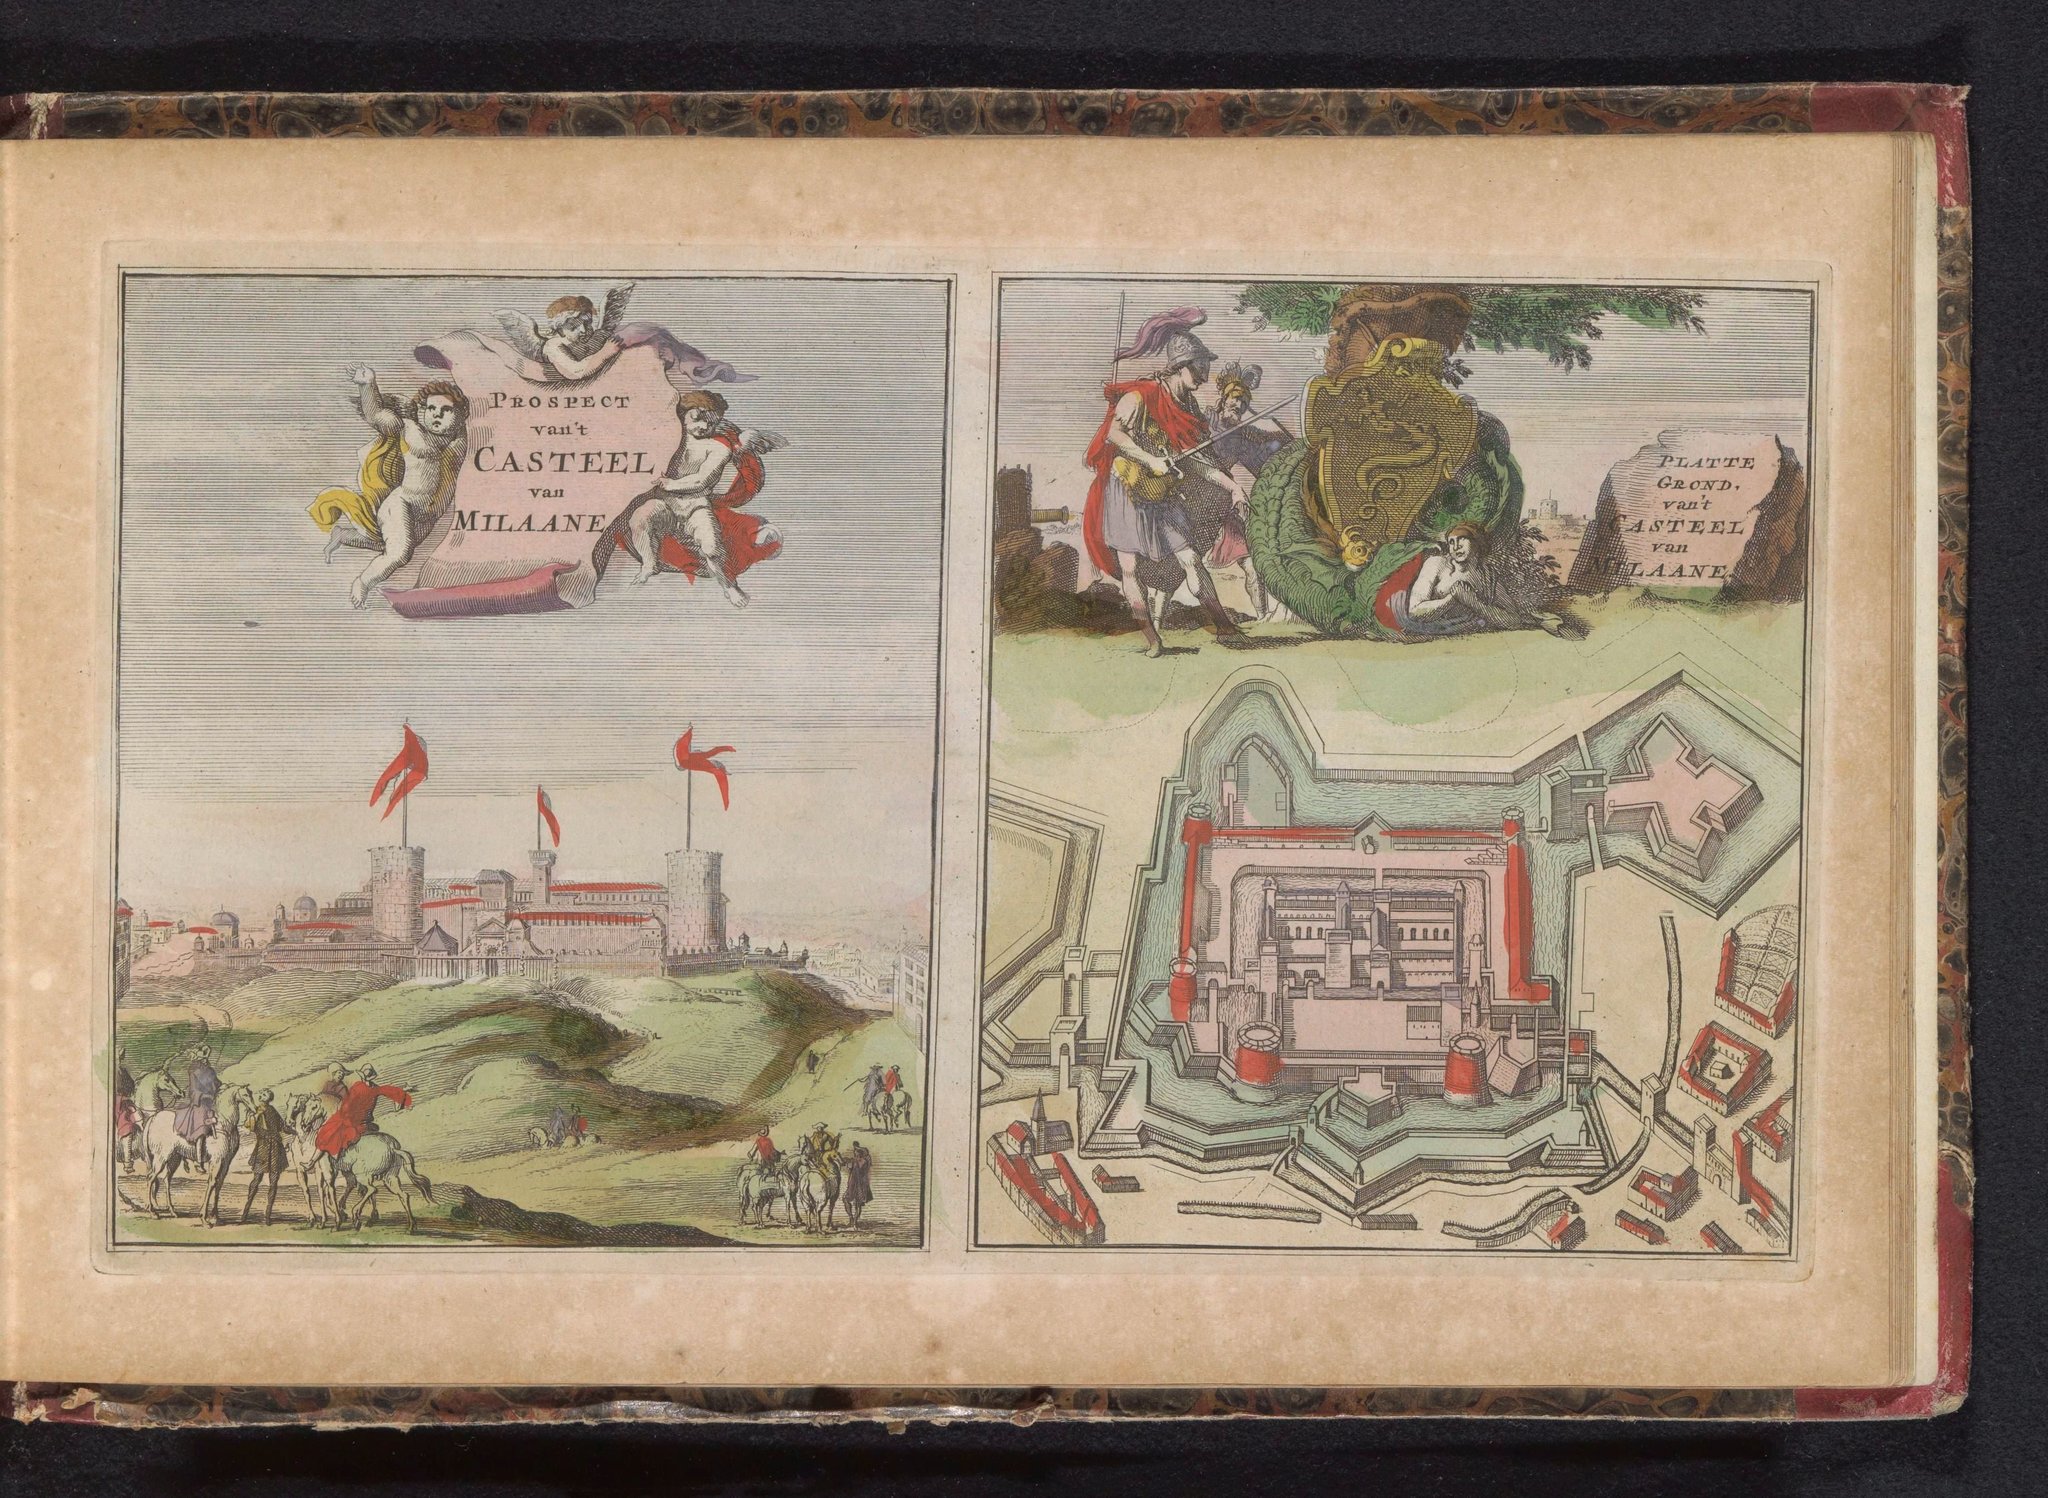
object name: print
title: Prospect van 't Casteel van Milaane / Platte Grond, van 't Casteel van Milaane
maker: Anonymous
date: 1735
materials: paper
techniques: engraving, etching, hand coloring, lacquer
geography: northern netherlands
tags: fortress, castle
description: Blad met twee voorstellingen: gezicht op en plattegrond van de Castello Sforza te Milaan. Onderdeel van een atlas met 223 kaarten van landen en steden en oorlogstaferelen in Europa in de periode ca. 1690-1735.